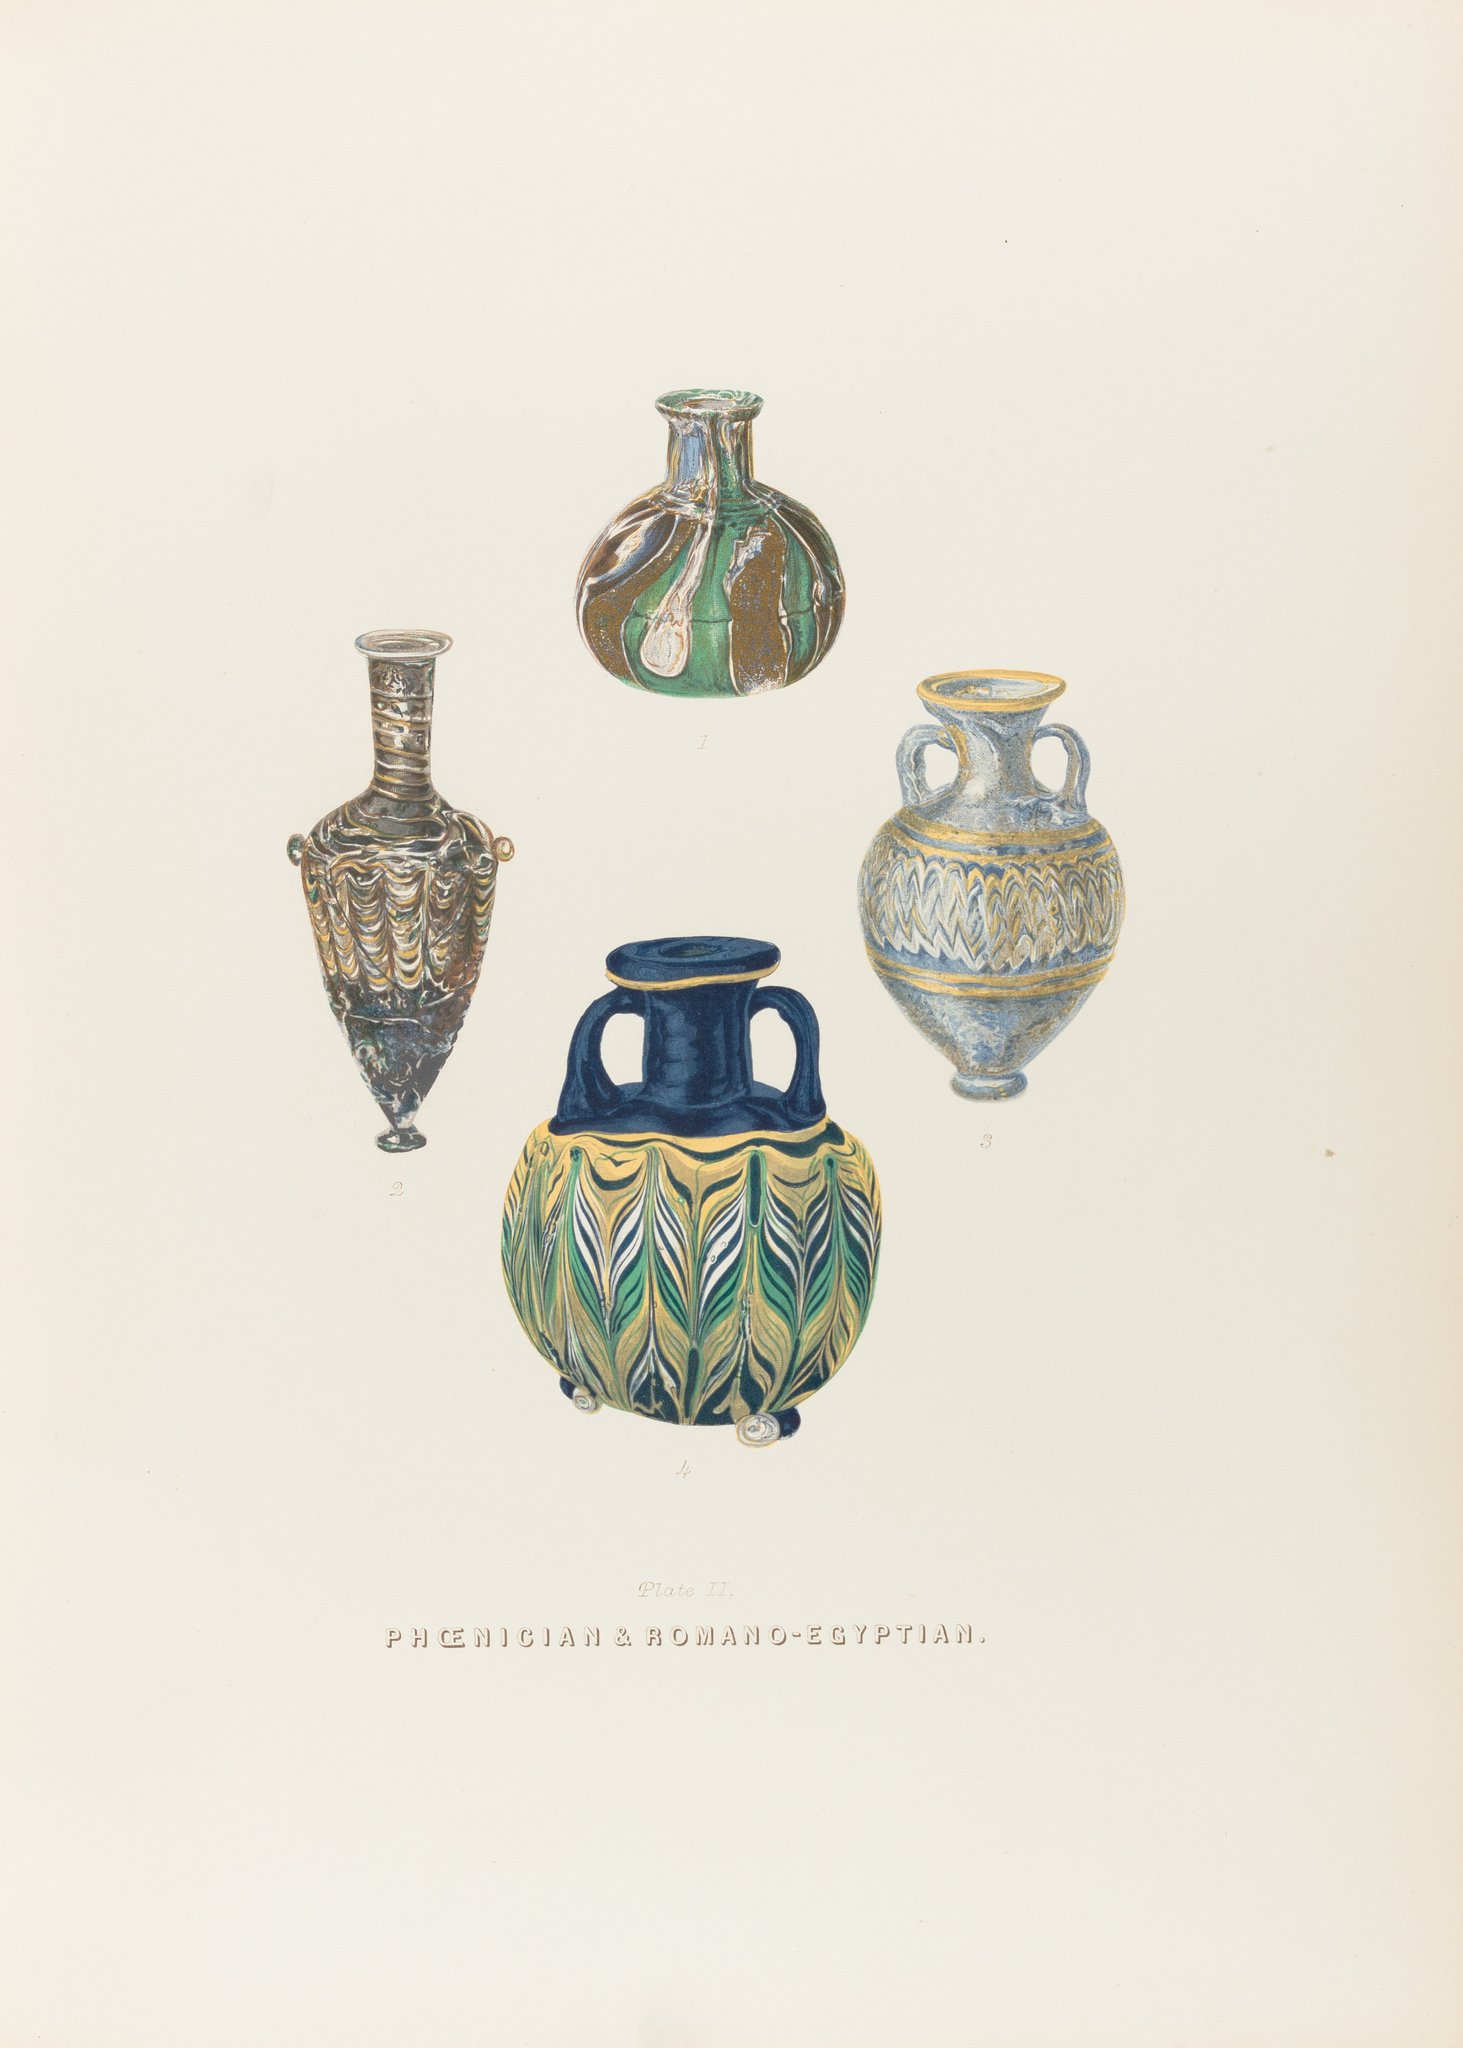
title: Catalogue of the collection of glass formed by Felix Slade : with notes on the history of glass making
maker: alexander nesbitt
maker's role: author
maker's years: 1817-1886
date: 1871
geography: england